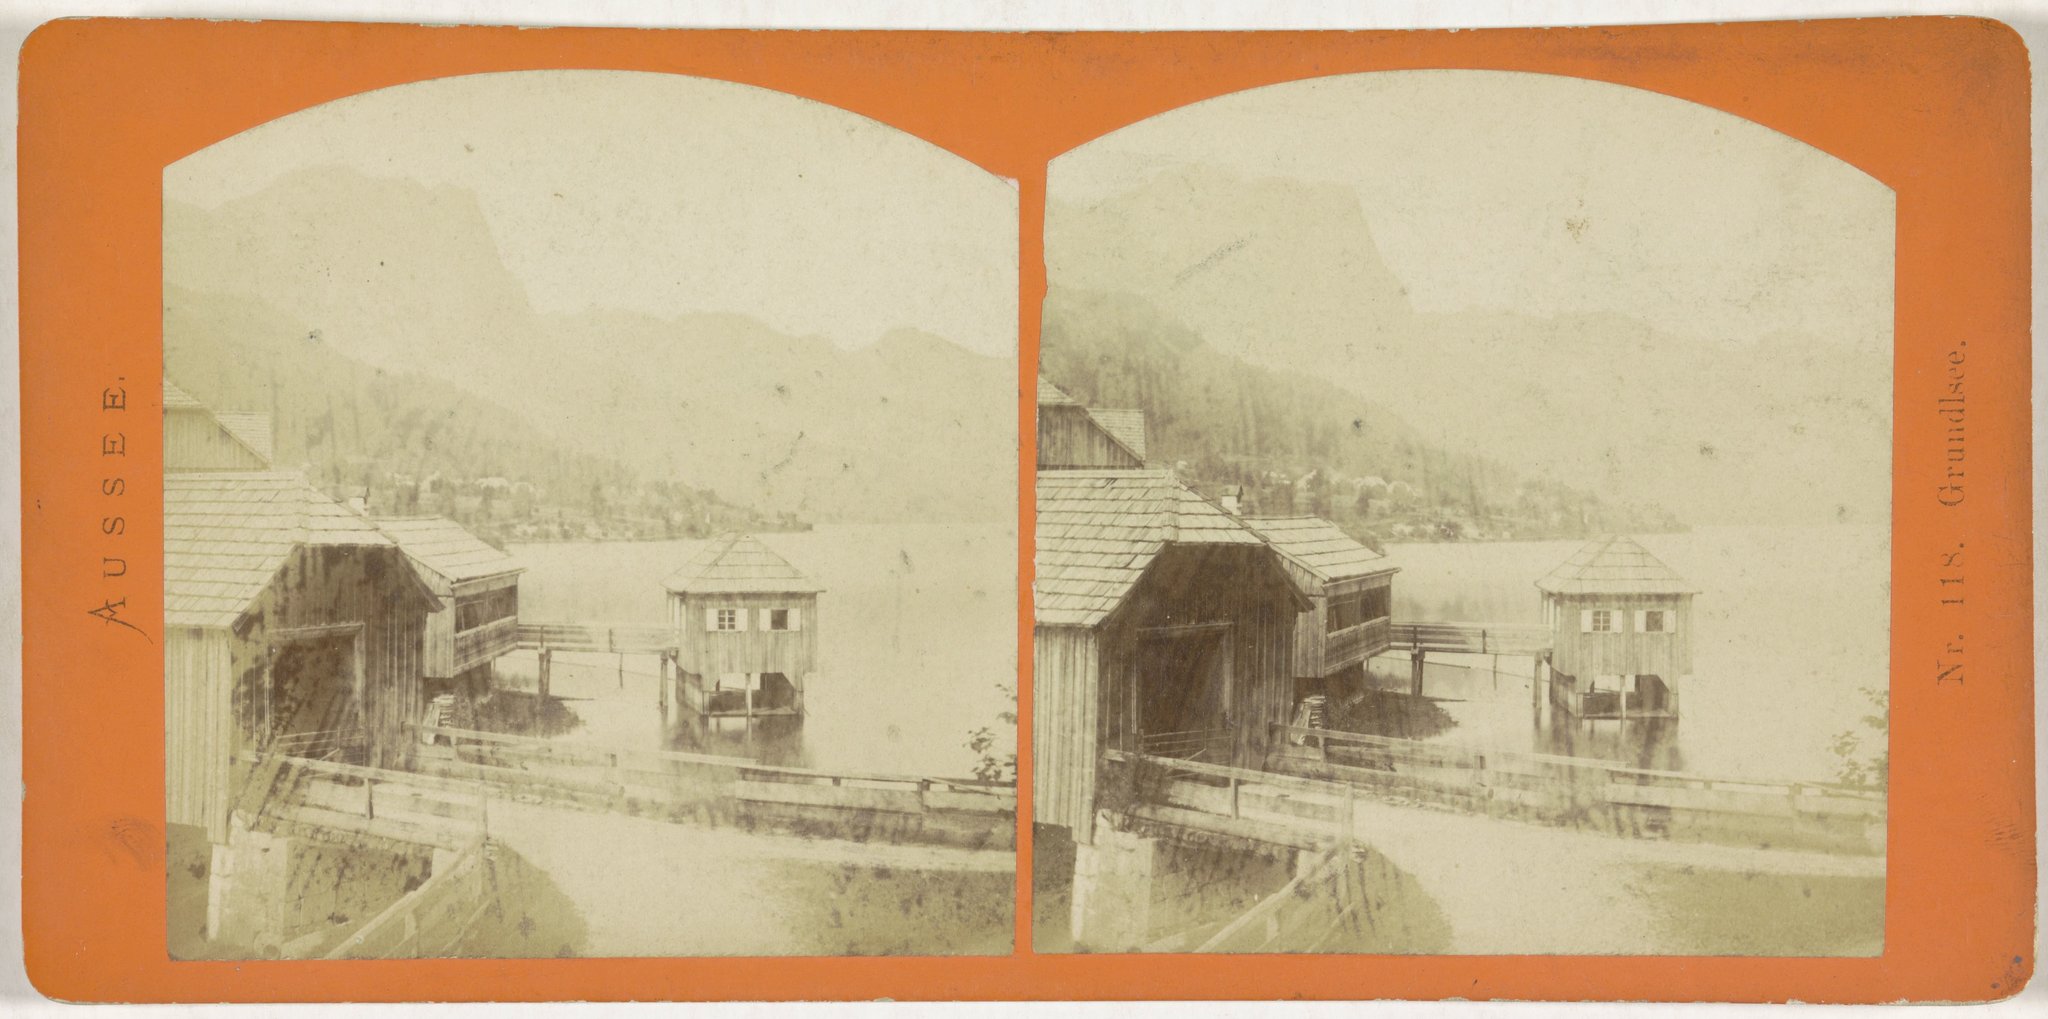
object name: stereograph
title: Grundlsee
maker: Anonymous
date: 1862-1880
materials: cardboard, paper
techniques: albumen print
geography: grundlsee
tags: lake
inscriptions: number: ‘Nr. 118’